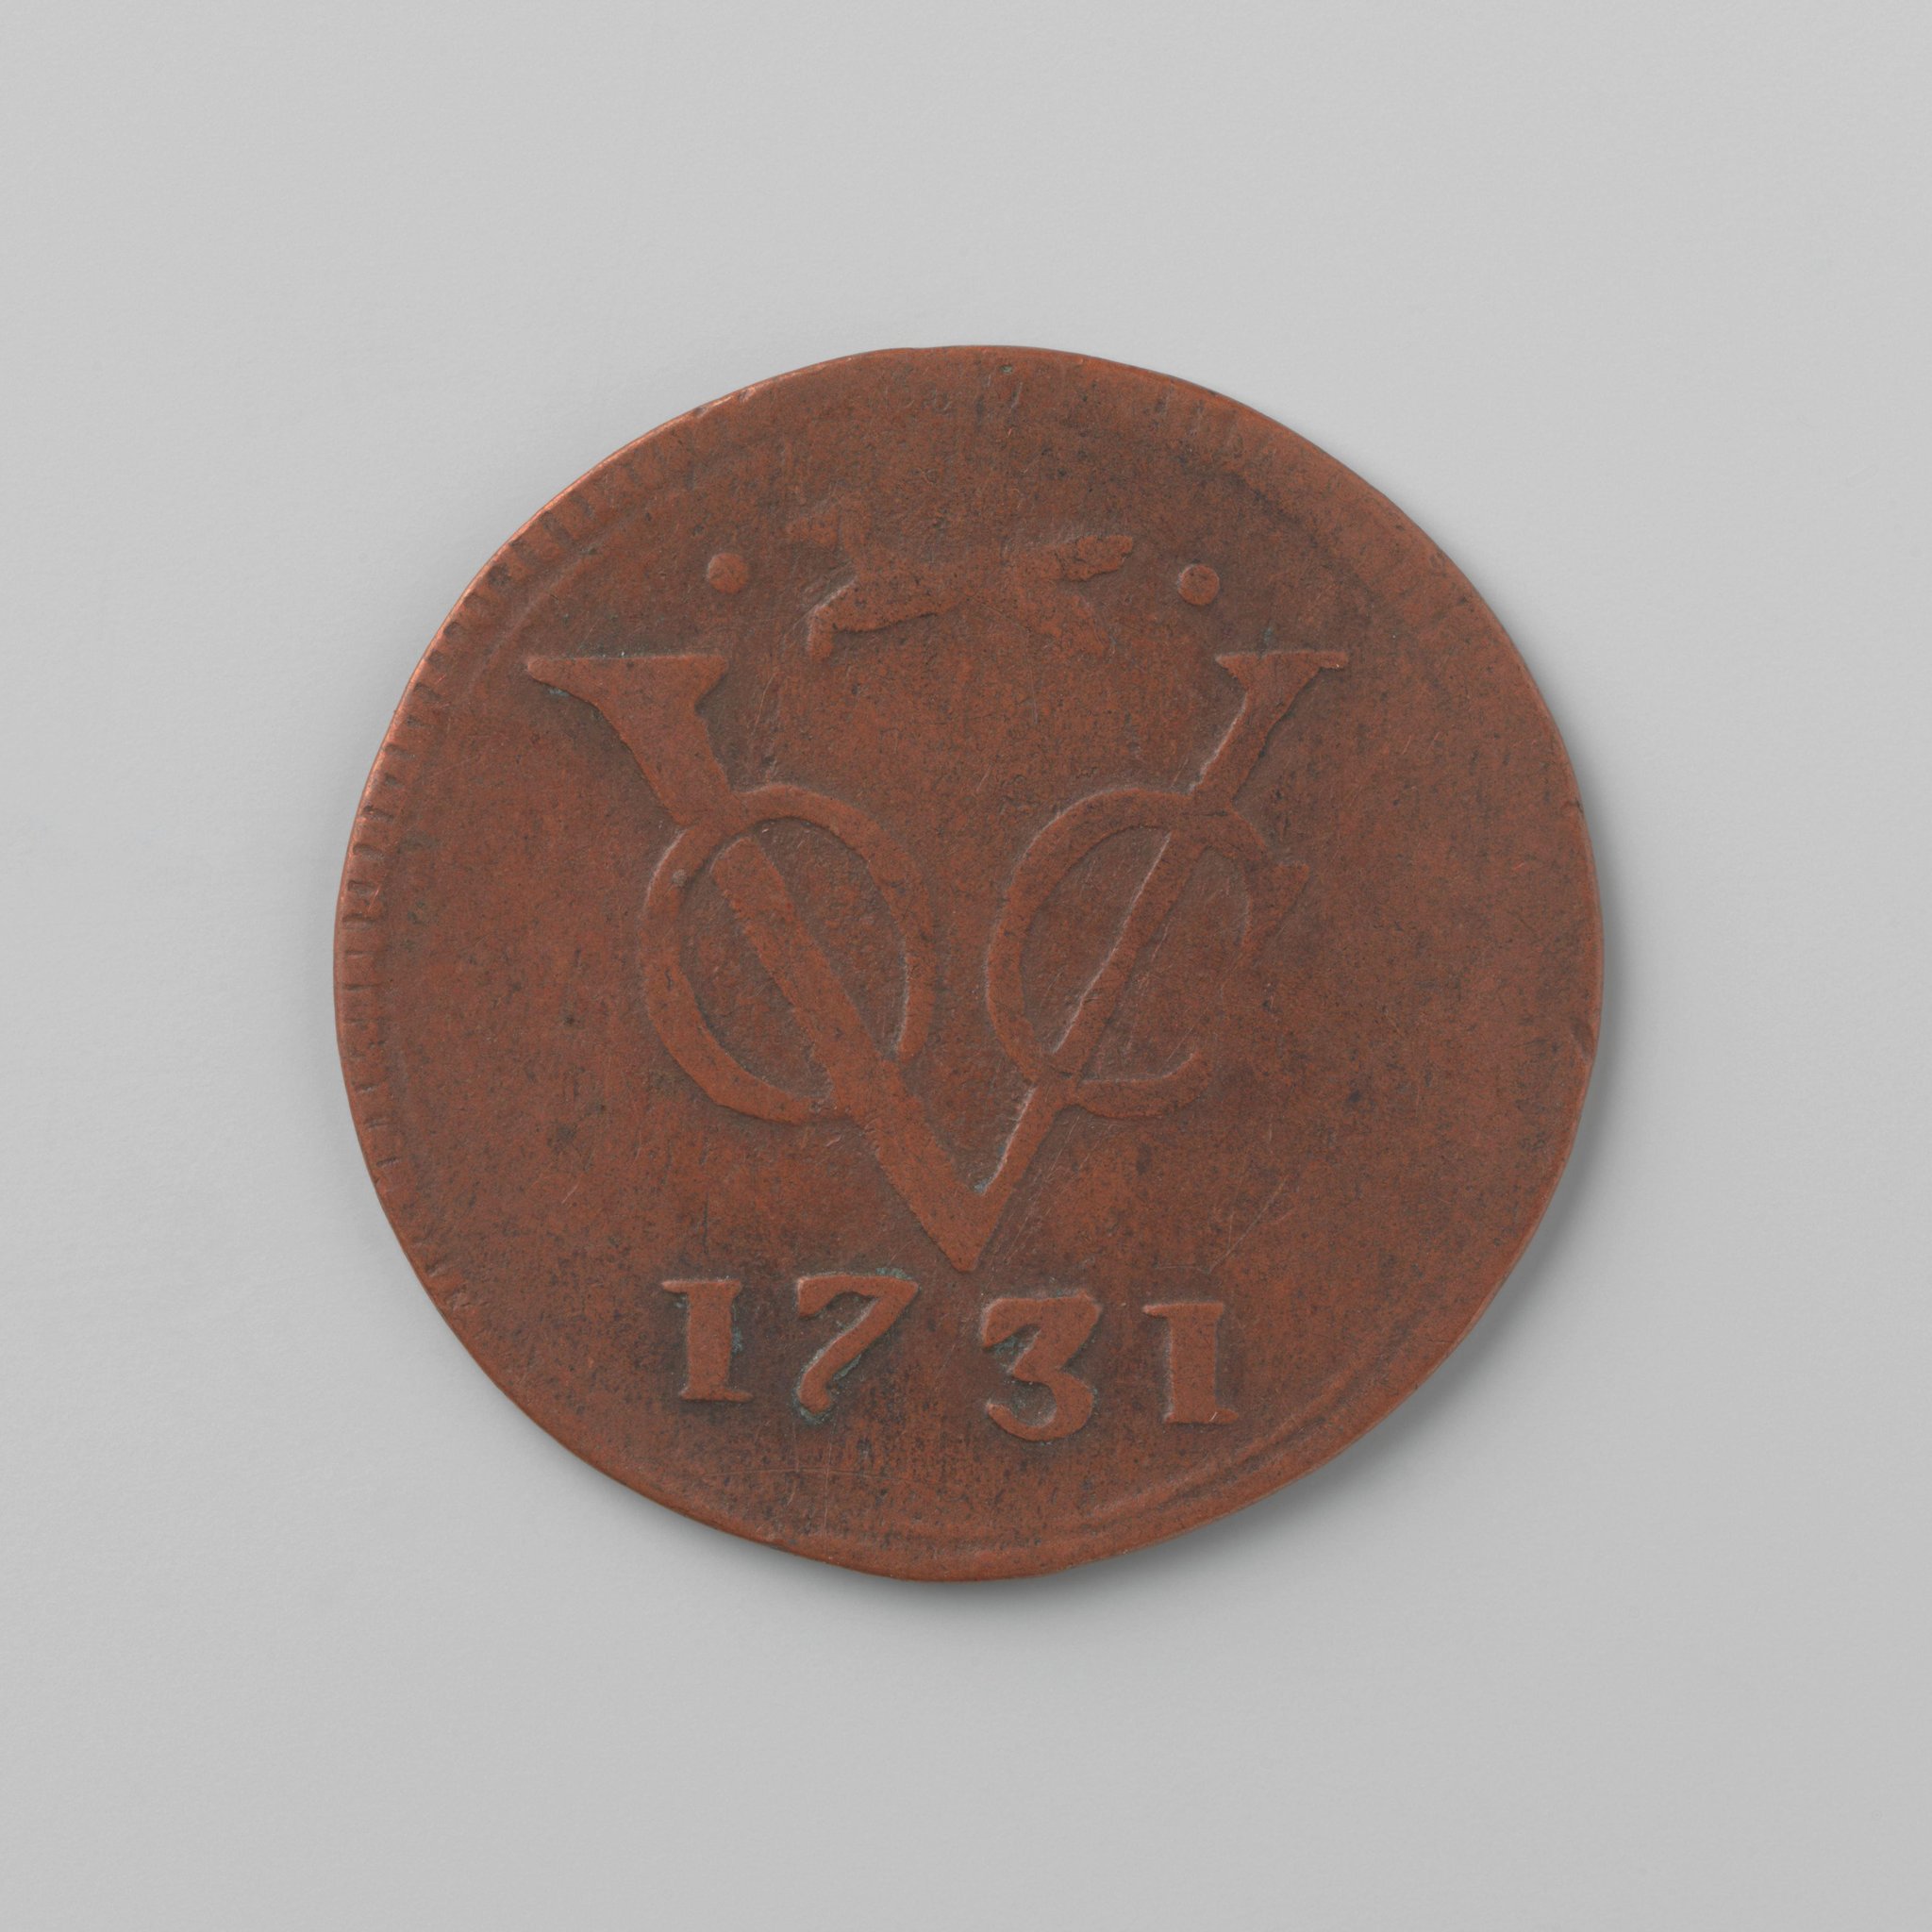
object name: coin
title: Duit van de VOC uit Gelderland,1731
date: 1731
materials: copper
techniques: striking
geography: harderwijk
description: Koperen munt. Voorzijde: tussen wapenspreuk gekroond wapenschild van Gelderland. Keerzijde: monogram van de VOC, waarboven muntmeesterteken en waaronder jaartal. Gladde rand.